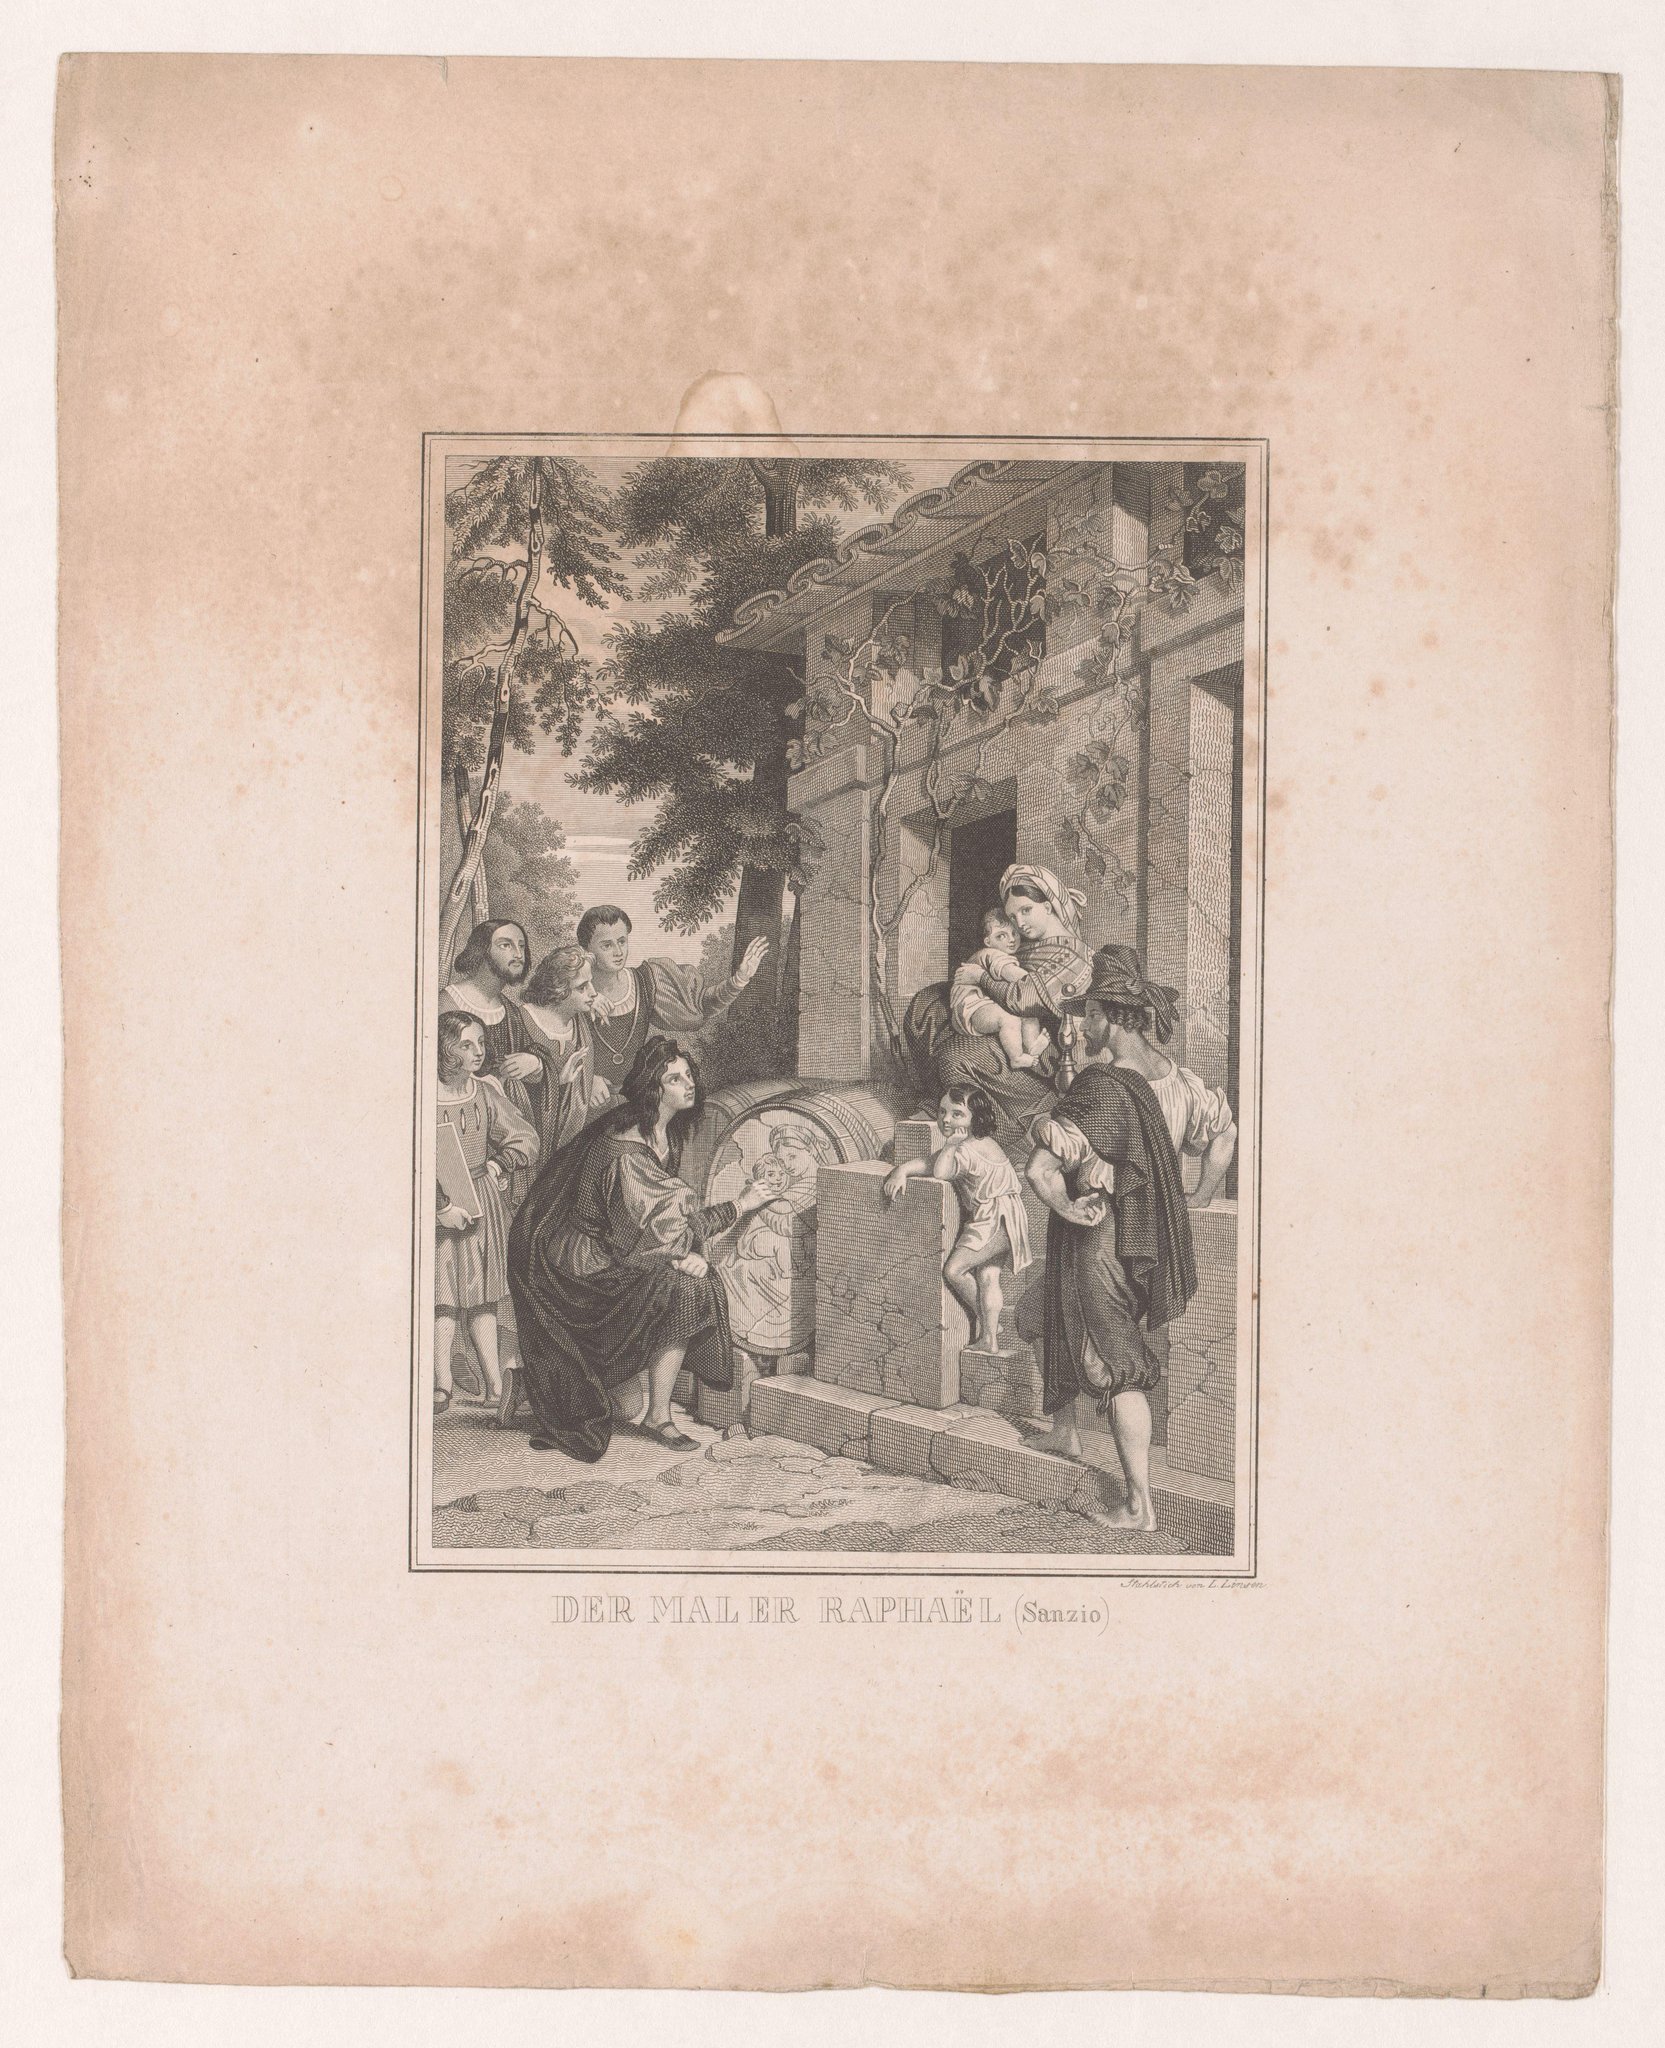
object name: print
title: Der Maler Raphaël (Sanzio)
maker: l. linsen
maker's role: print maker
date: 1839-1856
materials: paper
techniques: engraving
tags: rome, painter, rafaël, portrait, self-portrait of painter, the audience ~ art performance, mary sitting or enthroned, the christ-child in front of her, sitting in her lap (or in front of her bosom)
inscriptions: collector's mark: Lugt 2228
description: De voorstelling is een bekend werk door Rafaël getiteld 'Madonna della Seggiola' uit 1514. Tekst in het Duits in de ondermarge.